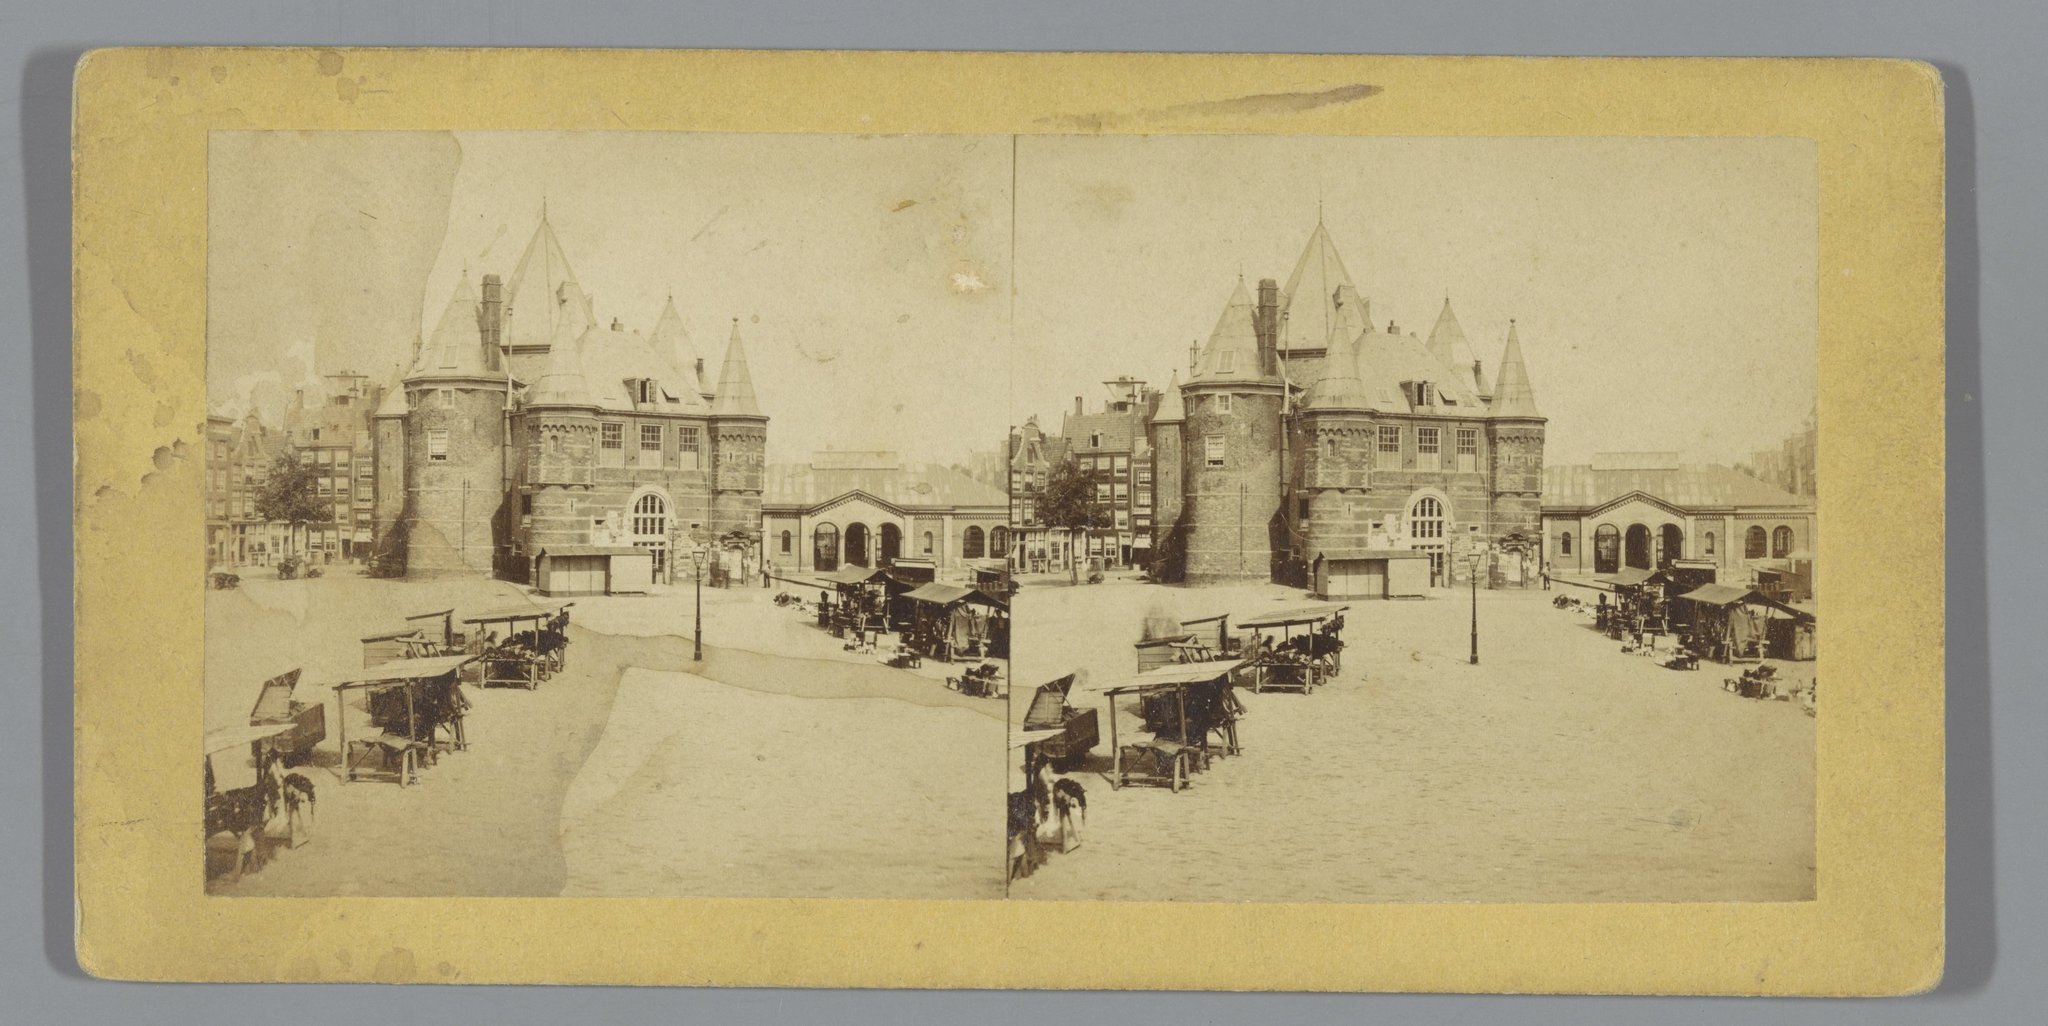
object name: stereograph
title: Nieuwmarkt met de Waag en de Gemeentelijke Vishal, Amsterdam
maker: Anonymous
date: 1860-1870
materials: cardboard, paper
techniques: albumen print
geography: amsterdam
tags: square, place, circus, etc., market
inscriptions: inscription: ‘C.P. Staalman/ Amsterdam’, inscription: ‘Eglise de Moïse/ et Aaron/ Amsterdam/ Waag’